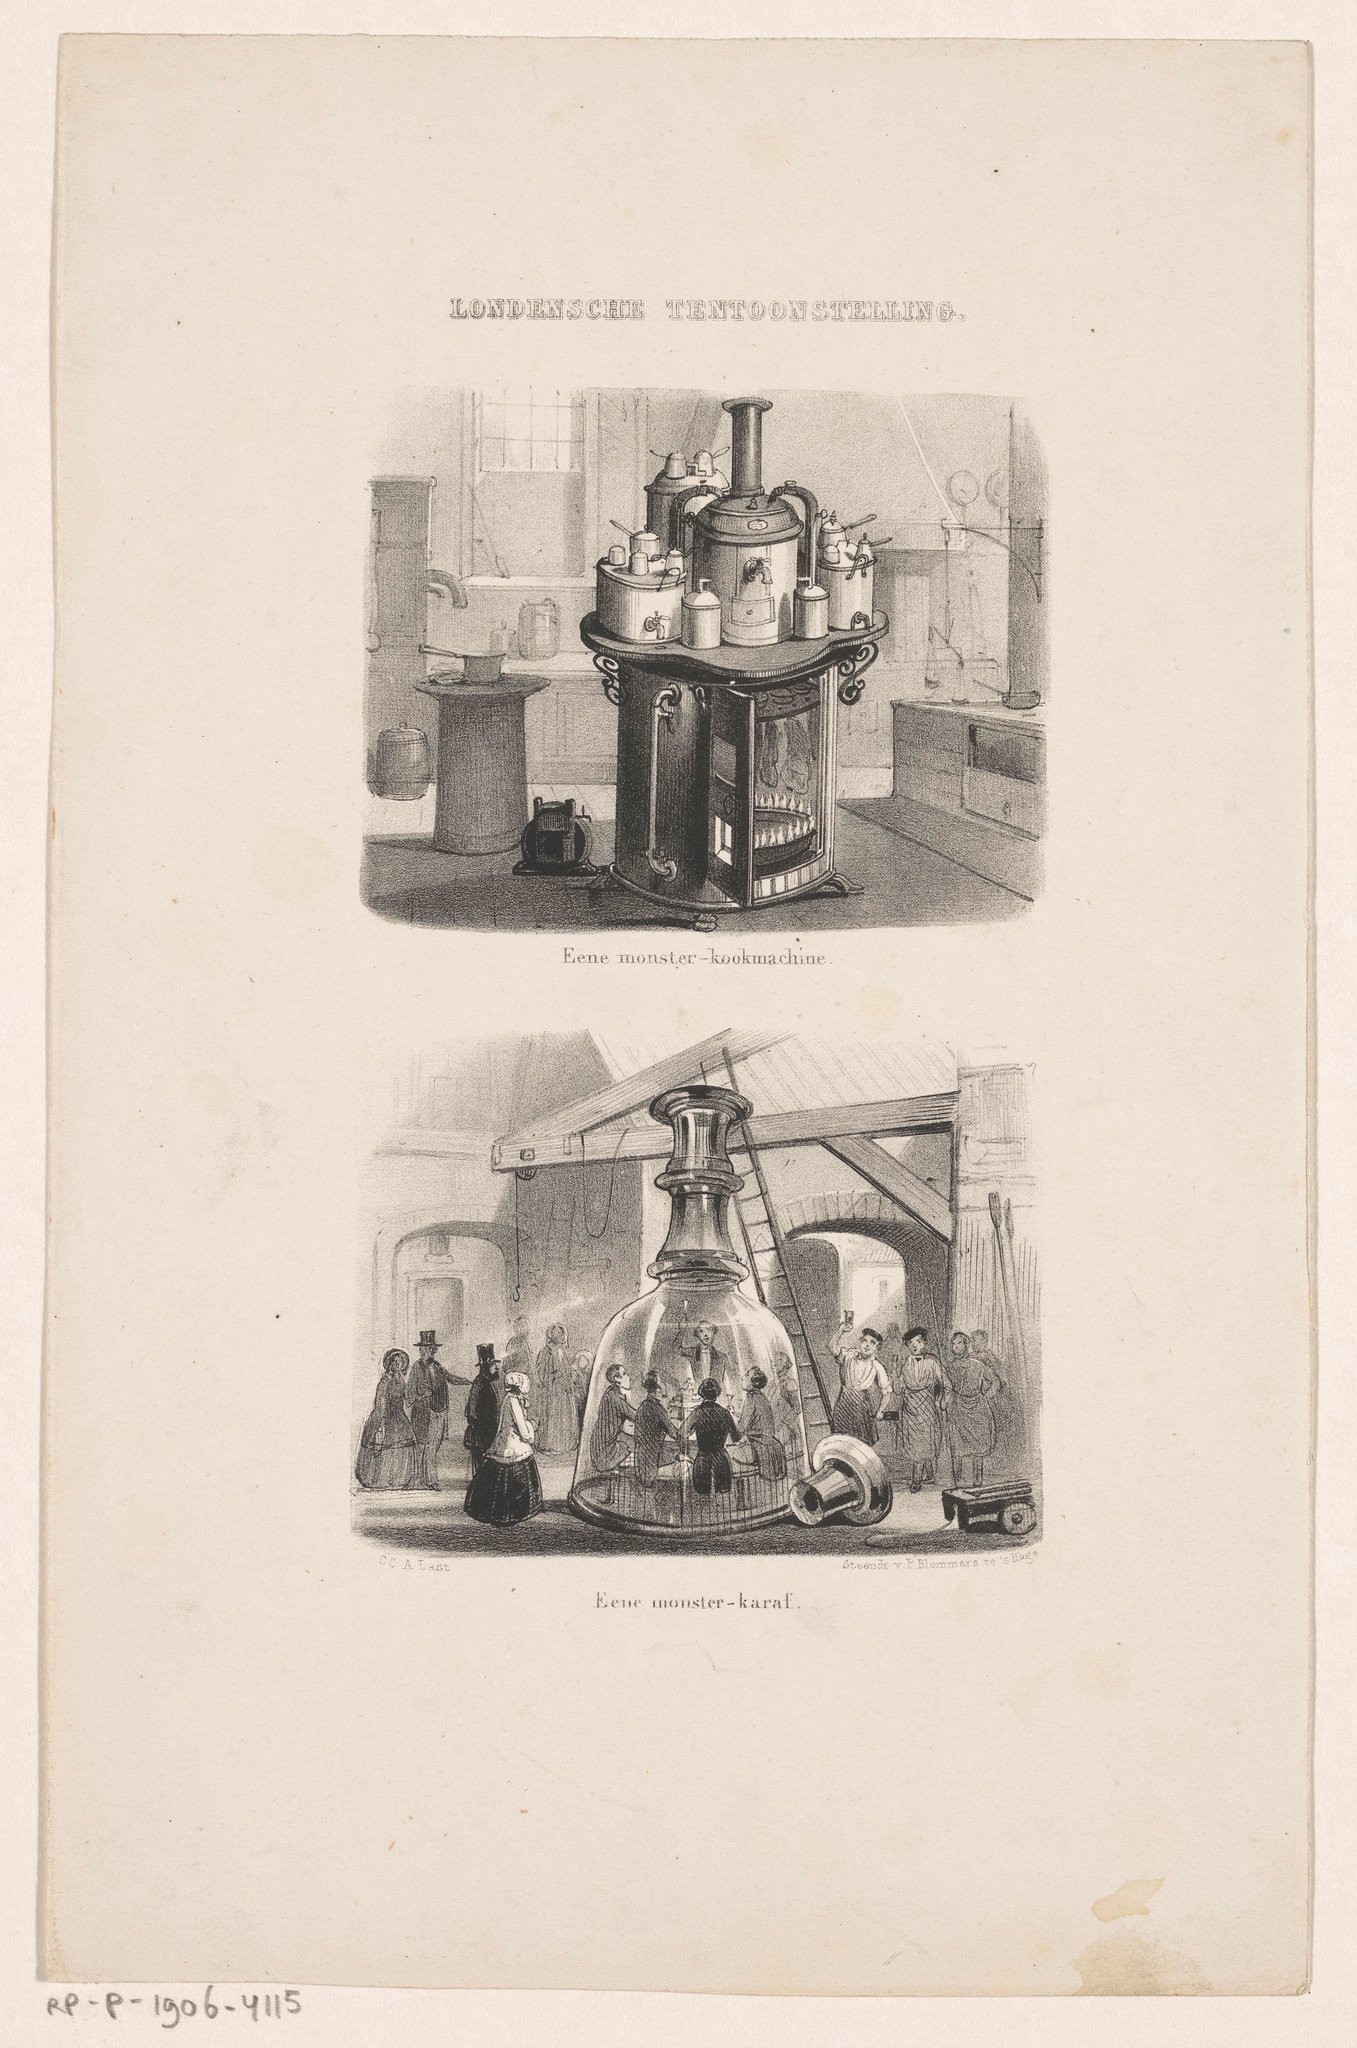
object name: print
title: Londensche tentoonstelling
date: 1842-1887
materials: paper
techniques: lithograph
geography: the hague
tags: world fair, world exhibition, heating stove, experiment, test ~ science and technology, chemical industry, london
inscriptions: collector's mark: Lugt 2228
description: Op een brandende kachel staan verschillende potten. Een groep mannen zit onder een grote glazen stolp.